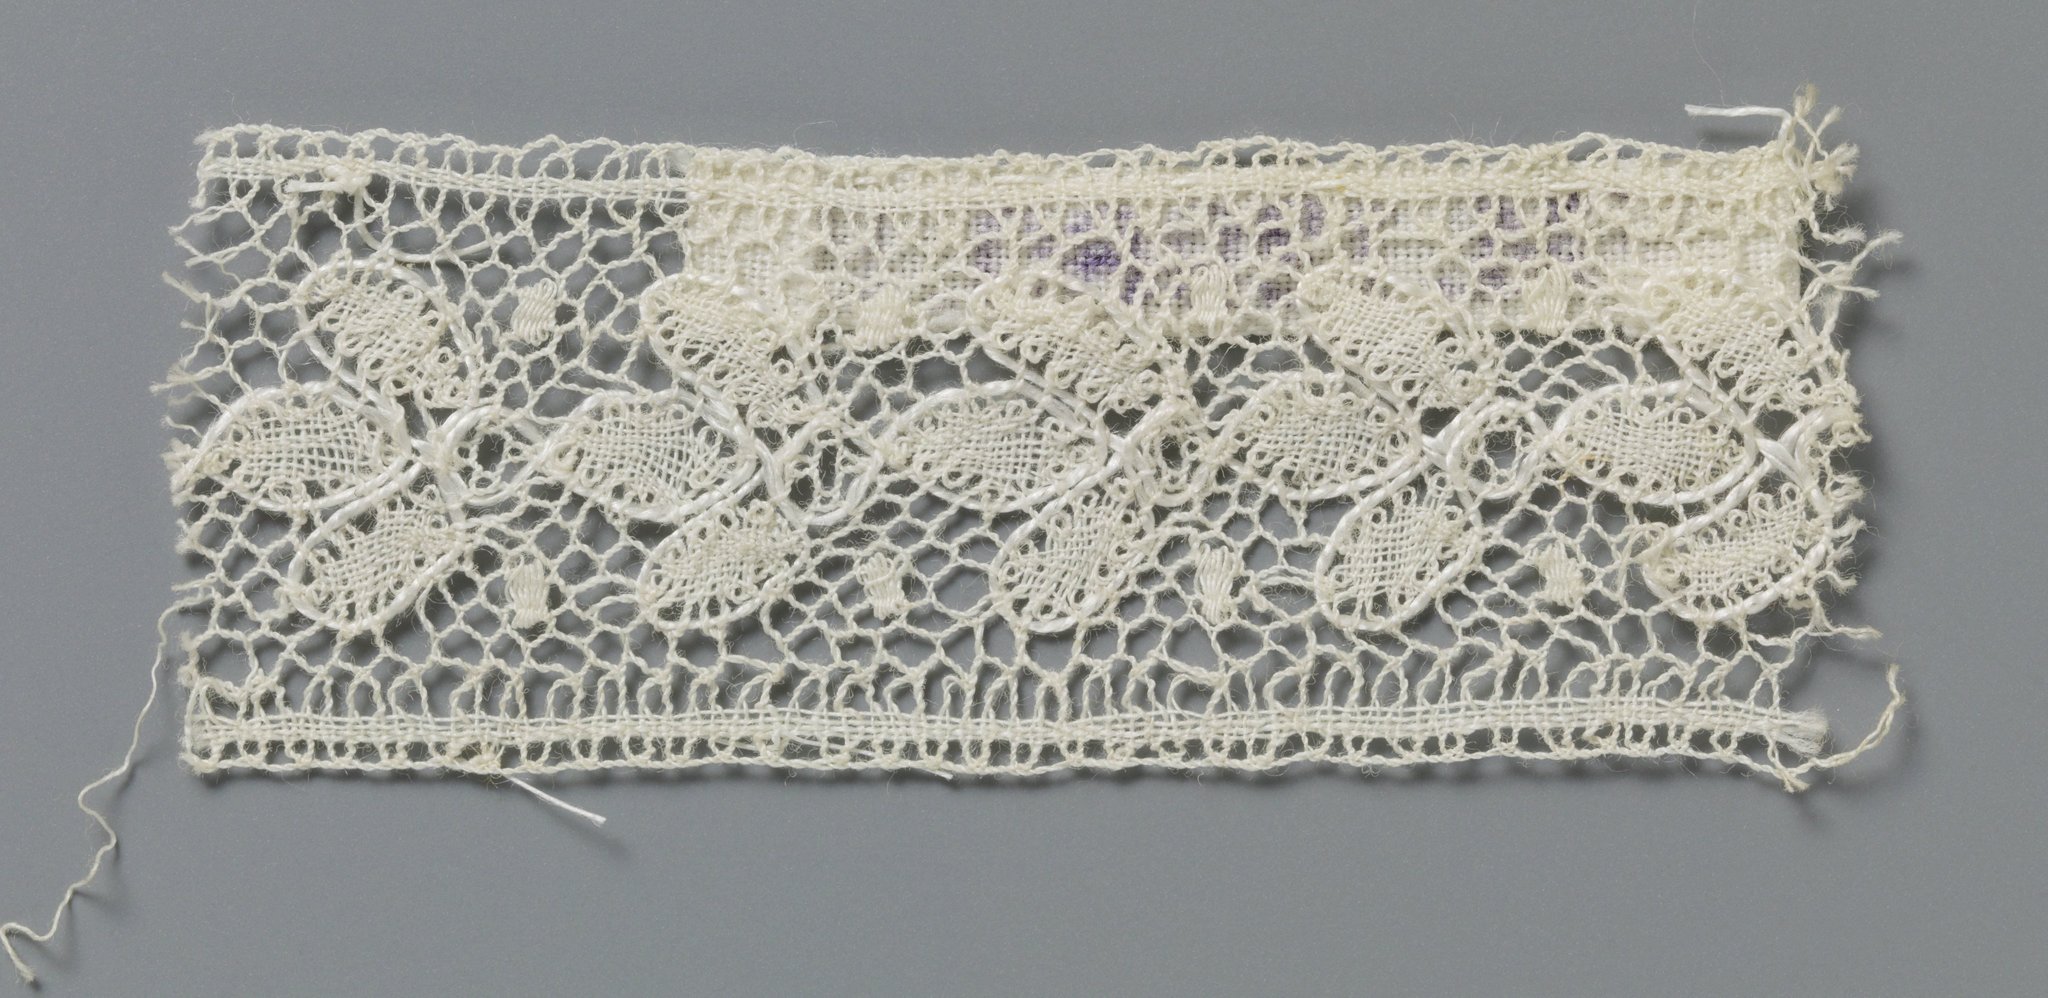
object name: strip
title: Strook kloskant met aaneengeschakelde drielobbige bladeren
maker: Anonymous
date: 1800-1899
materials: cotton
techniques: lace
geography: buckingham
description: Strook naturelkleurige kloskant, Buckingham-kant. Het zich herhalende en doorlopende patroon vormt een brede baan over de middenlijn van de strook. Het bestaat uit een aaneenschakeling van liggende drielobbige bladeren met een cirkeltje aan de basis. De lobben zijn gemaakt in linnenslag, elk cirkeltje bestaat uit een siermaas. Om zowel lobben als cirkeltje loopt een dikke en glimmende contourdraad. Boven en onder het cirkeltje staat een los vierkant moesje, gemaakt in vormslag. De motieven zijn met elkaar verbonden door een maasgrond, een tulegrond. Boven- en onderzijde van de strook zijn recht afgewerkt.